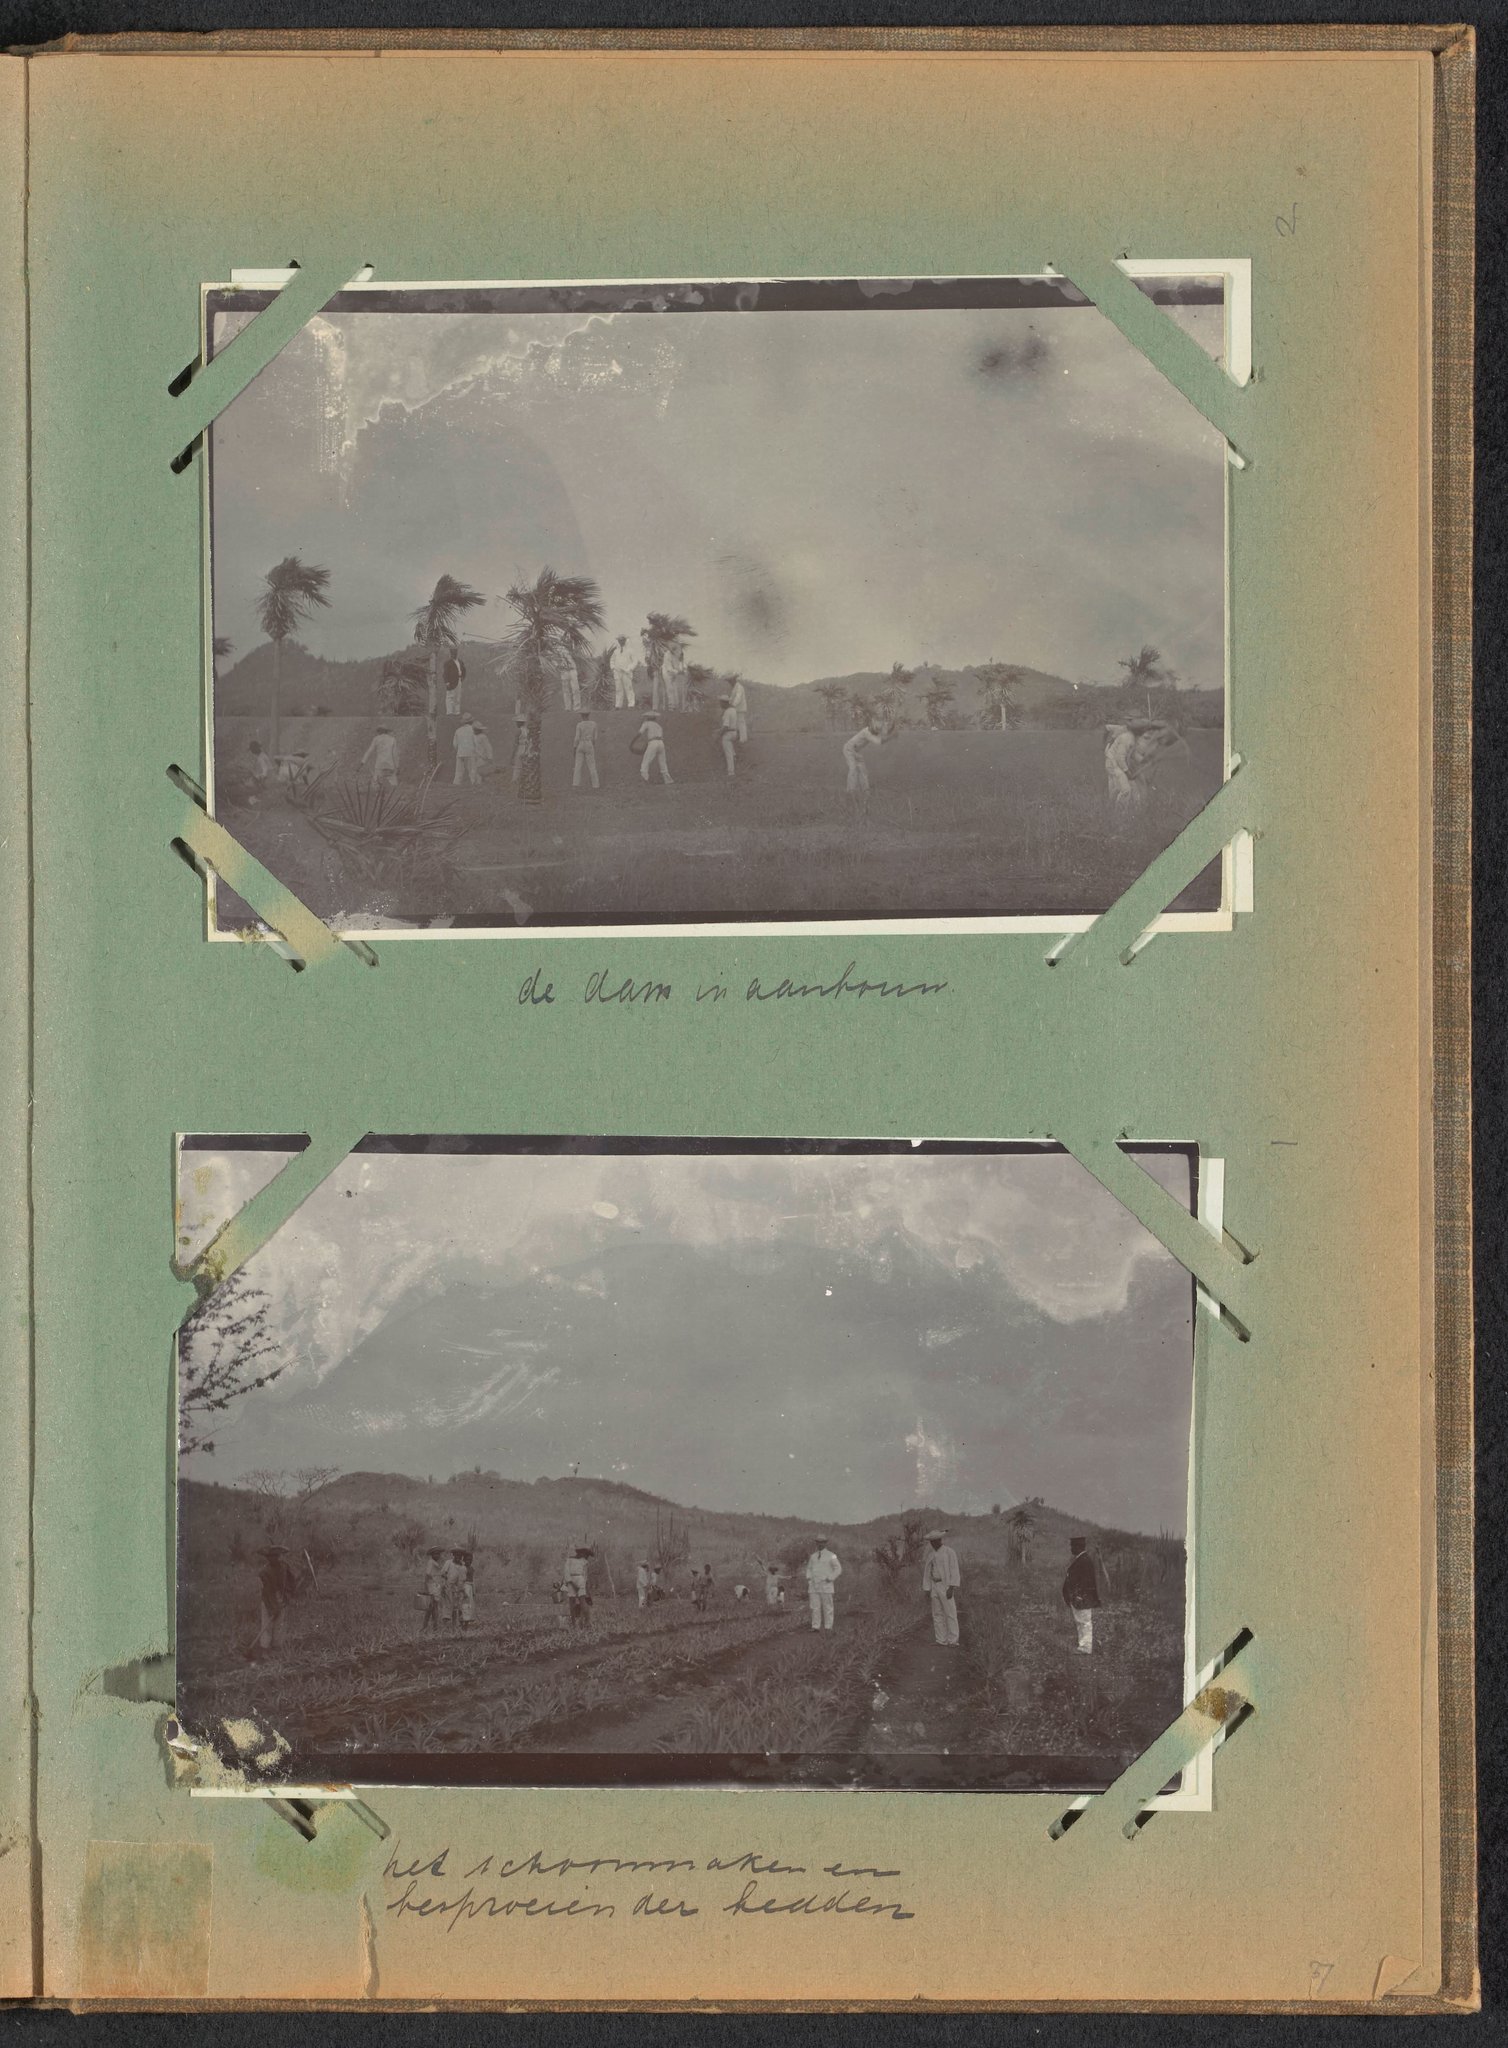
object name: photograph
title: Klaarmaken van de bedden voor beplanting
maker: Anonymous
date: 1912-1913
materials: paper, photographic support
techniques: gelatin silver print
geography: curacao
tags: plantation, (non-fruit) products of plants or trees: sisal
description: Klaarmaken van de bedden voor beplanting, waarschijnlijk van sisal. Bij Plantage Mount Pleasant op Curaçao. Onderdeel van het fotoalbum uit ca. 1912-1913 met 92 foto's van de plantages Peperpot en Dordrecht in Suriname en Mount Pleasant op Curaçao.